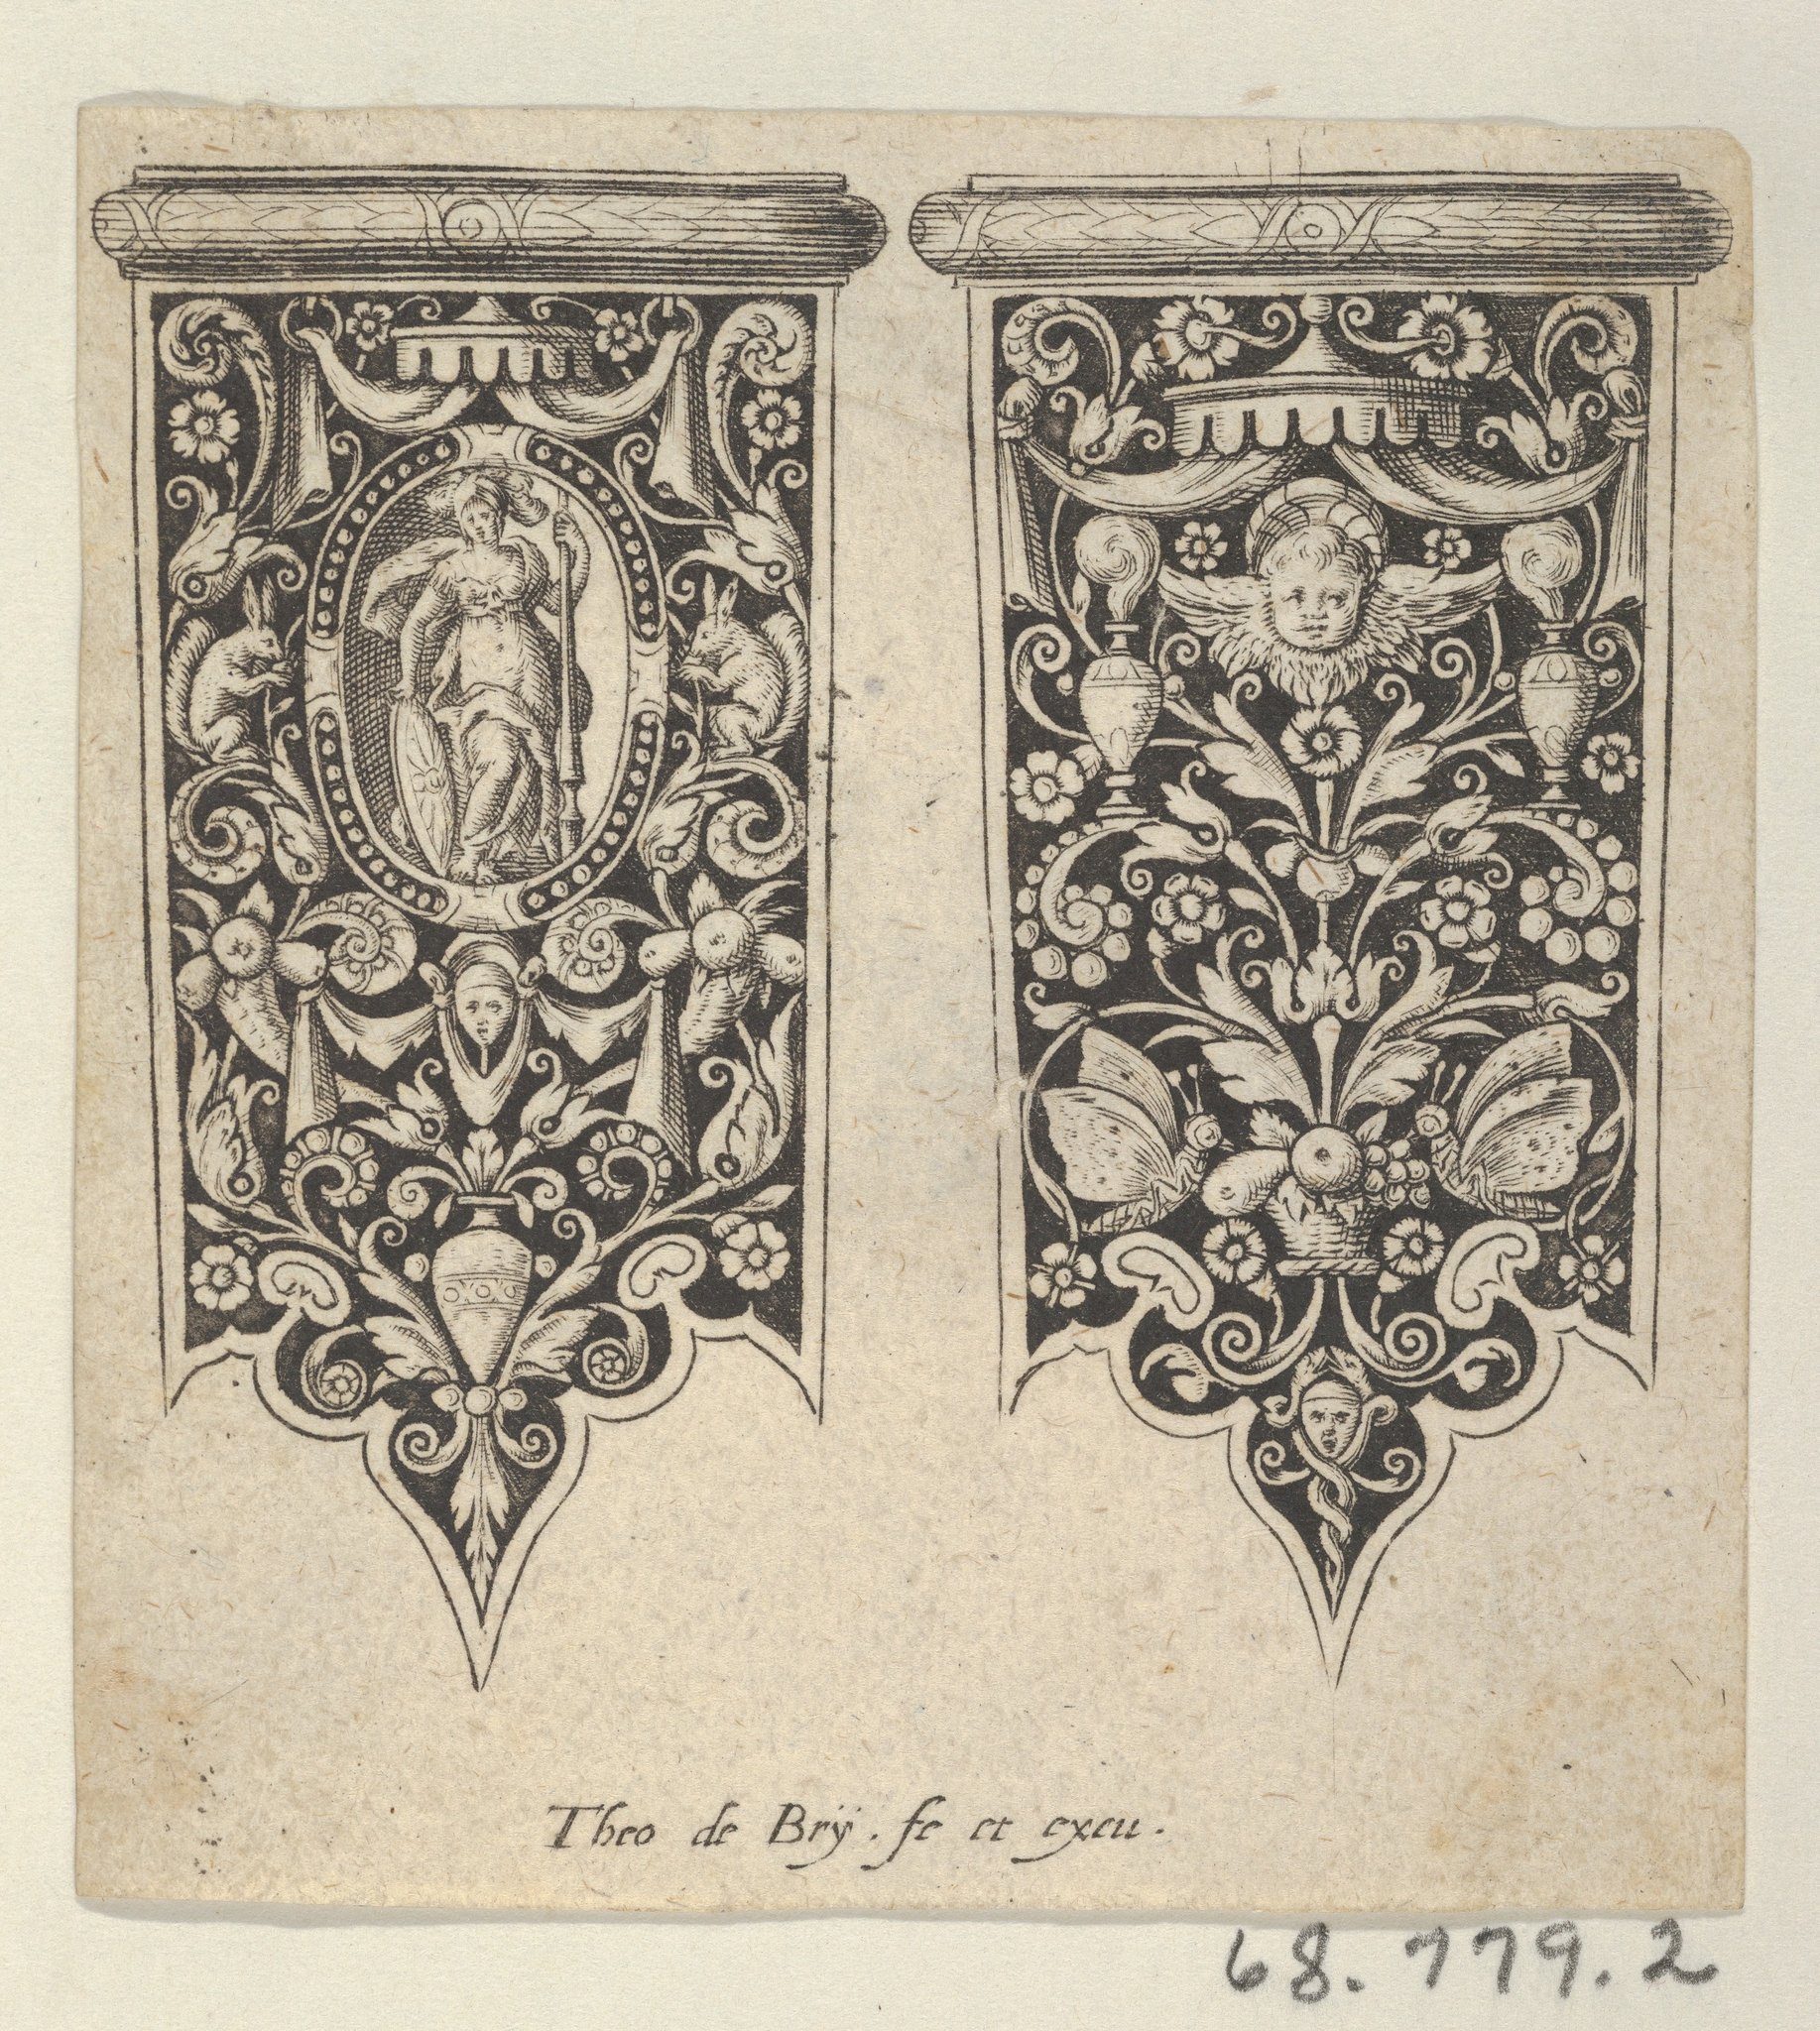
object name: print ornament architecture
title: Design for Knife Handles, from Mansches de Coutiaus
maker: johann theodor de bry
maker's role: artist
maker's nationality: netherlandish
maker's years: 1561-1623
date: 1580-1600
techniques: embroidery, engraving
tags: shields,fruit,women,flowers